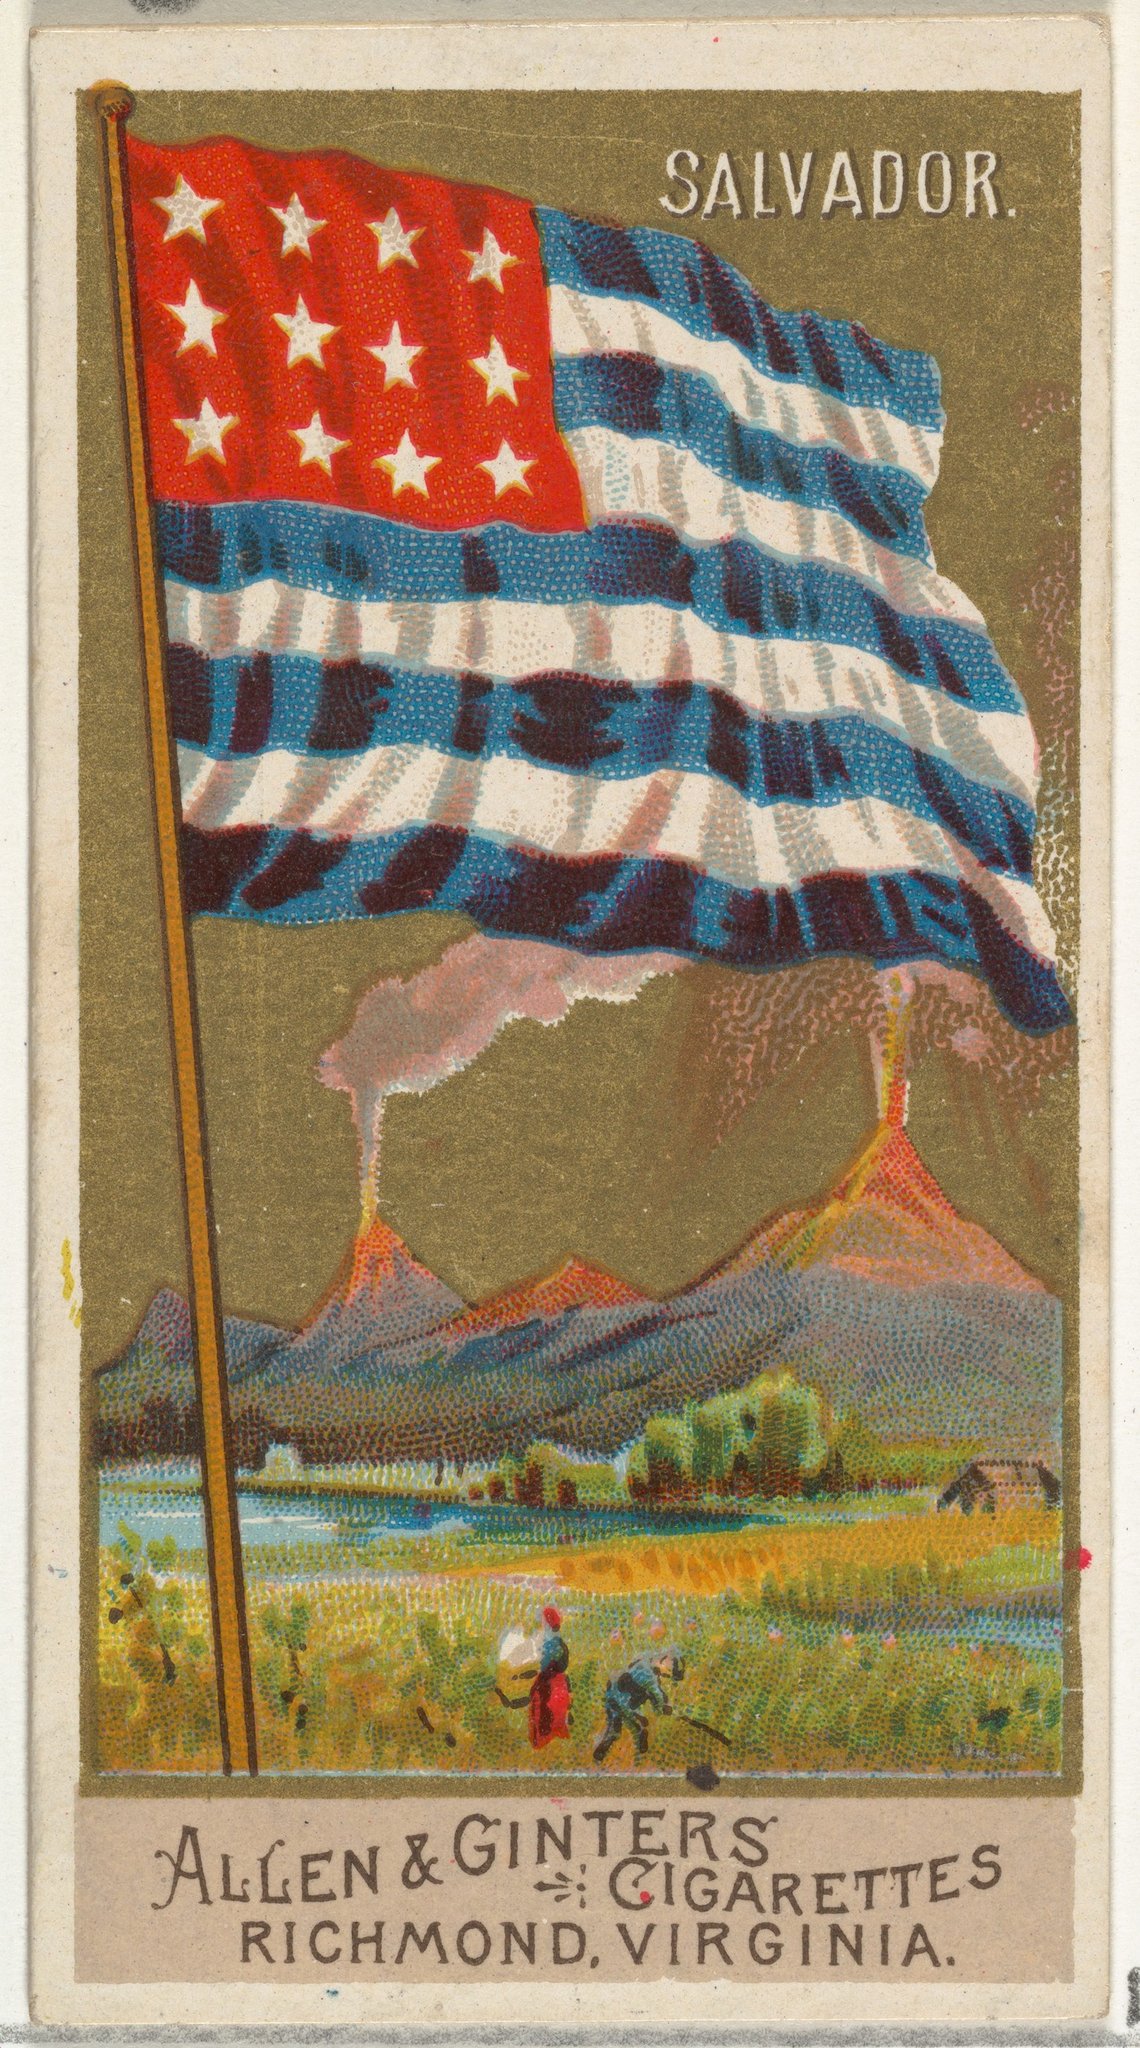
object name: print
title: Salvador, from Flags of All Nations, Series 2 (N10) for Allen & Ginter Cigarettes Brands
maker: allen & ginter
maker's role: publisher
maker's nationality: american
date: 1890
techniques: color lithograph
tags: flags